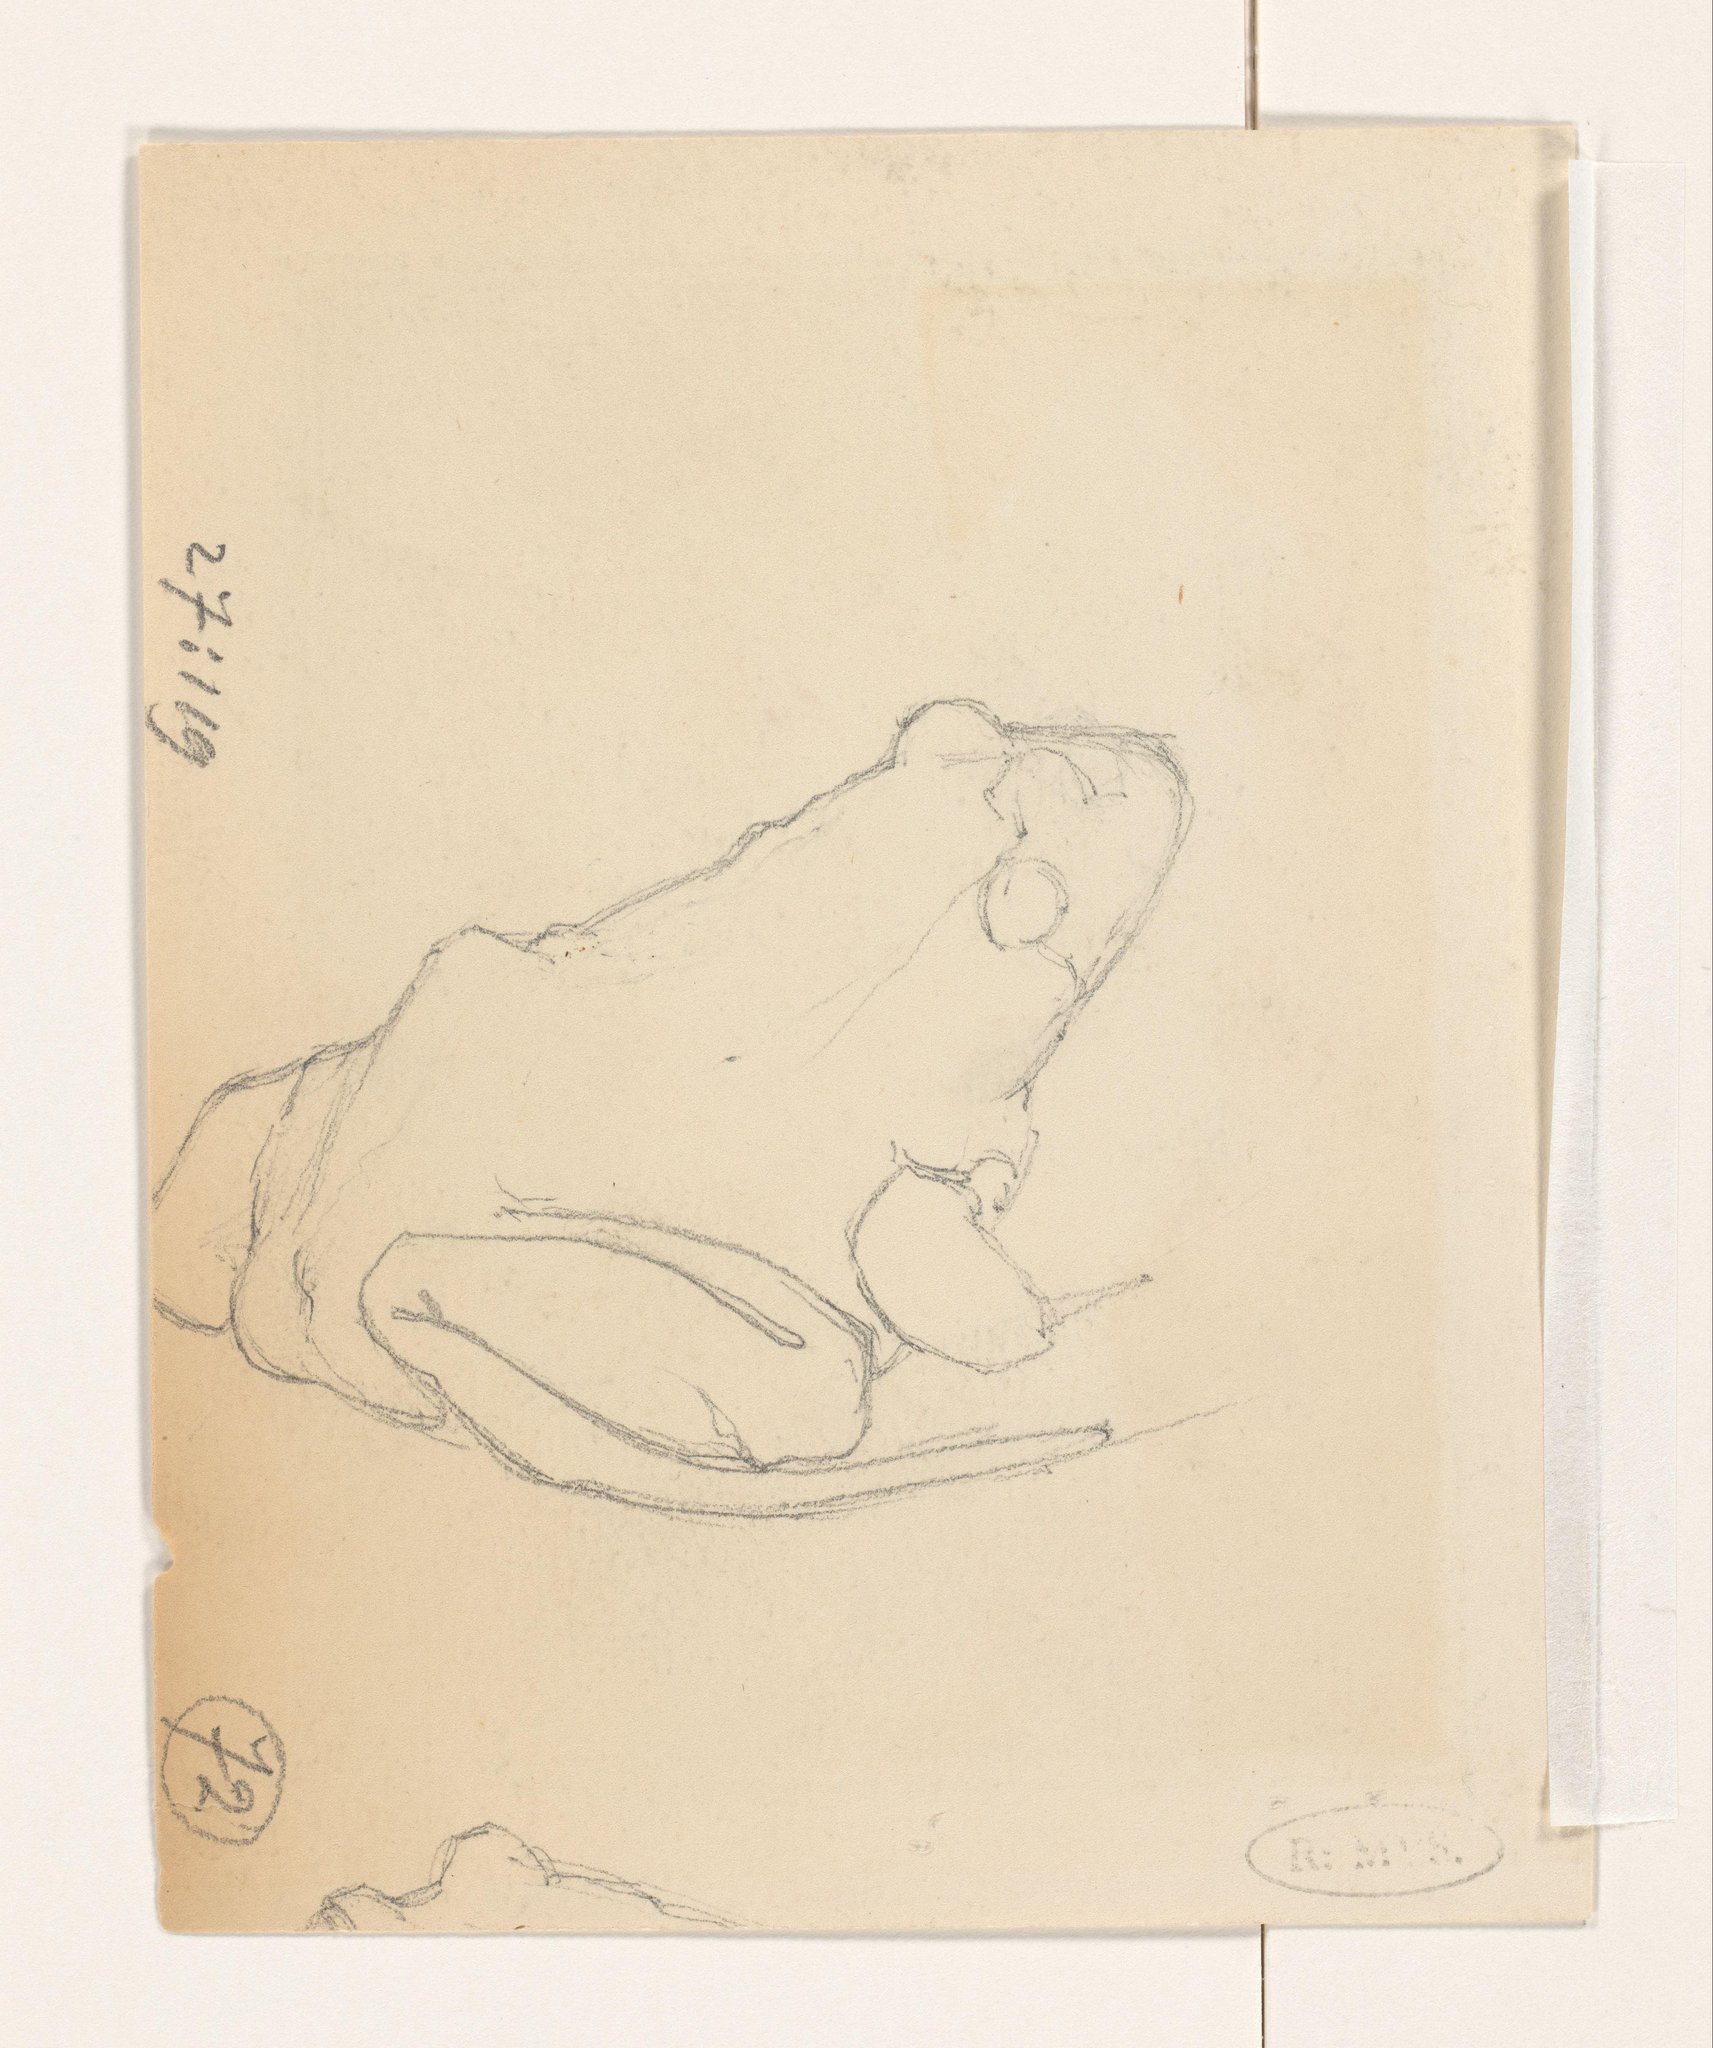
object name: drawing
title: Kikker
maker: julie de graag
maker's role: draughtsman, print maker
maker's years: 1877-1924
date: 1887-1924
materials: paper, pencil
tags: tailless amphibians: frog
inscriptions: number: ‘72’